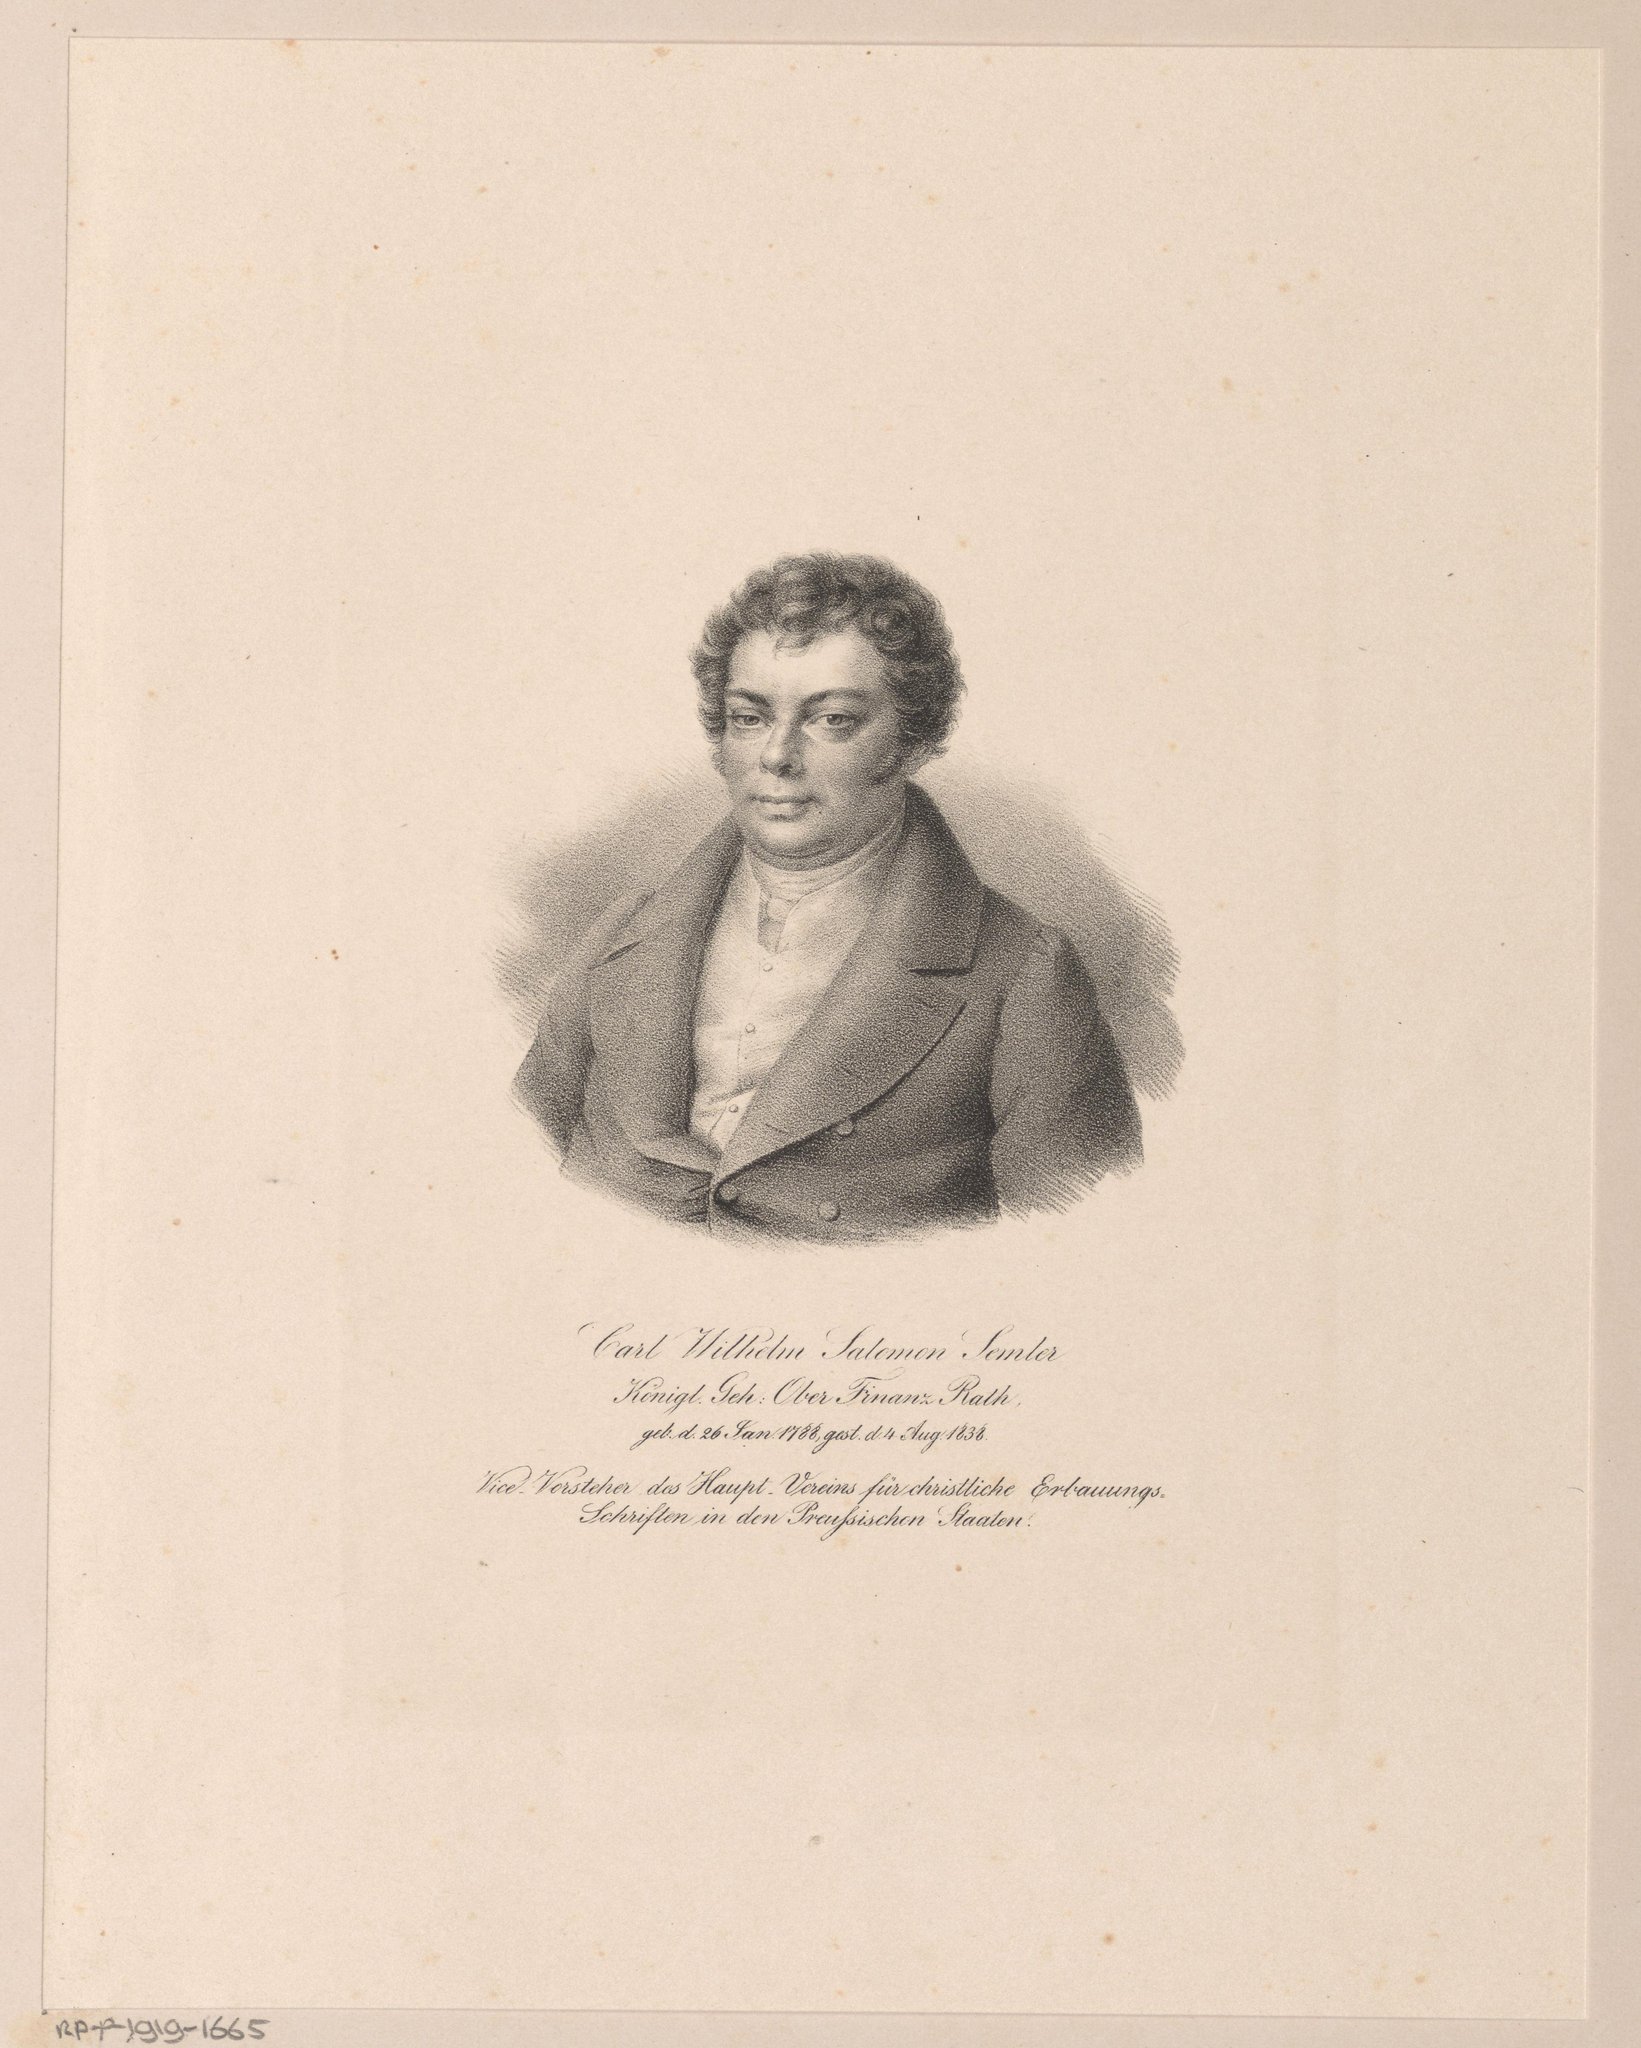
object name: print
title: Portret van Carl Wilhelm Salomon Semler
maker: Anonymous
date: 1838-1899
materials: paper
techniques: lithograph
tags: politician, official, official; civil servant; functionary (in general), historical persons, politician, e.g. party leader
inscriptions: collector's mark: Lugt 2228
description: Met vierregelig onderschrift in het Duits.